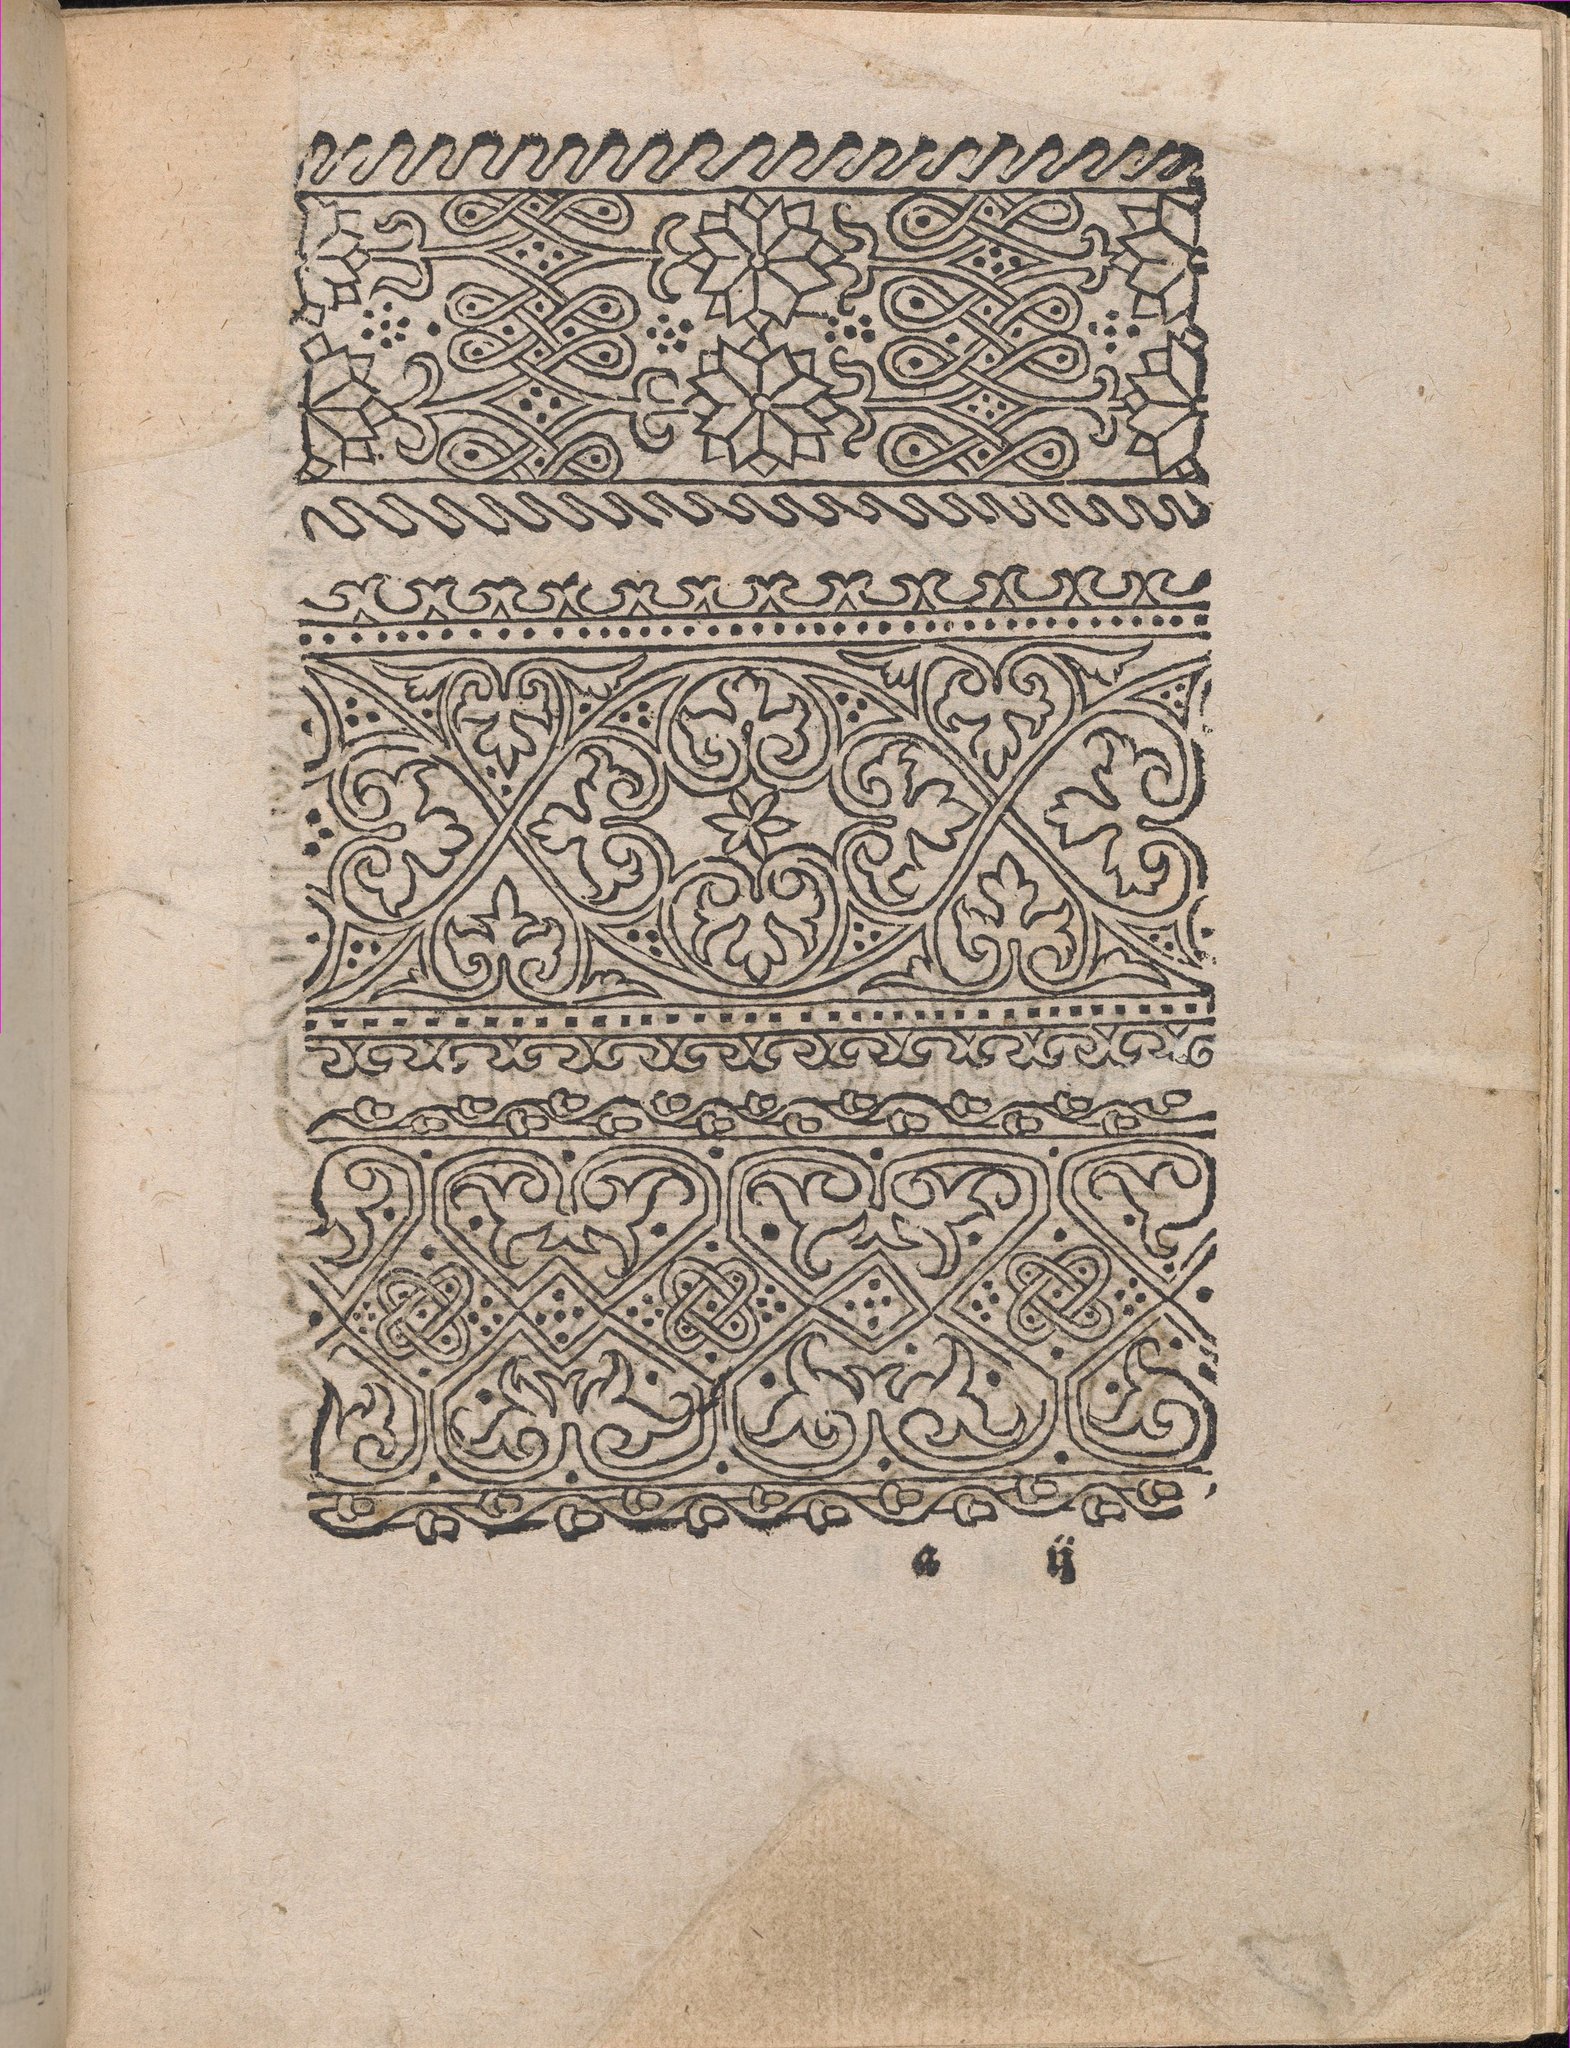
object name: book print ornament architecture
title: Modelbuch aller Art Nehens vn Stickens (Page 2r)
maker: christian egenolff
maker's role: publisher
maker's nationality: german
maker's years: 1502-1555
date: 1535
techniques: woodcut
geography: germany